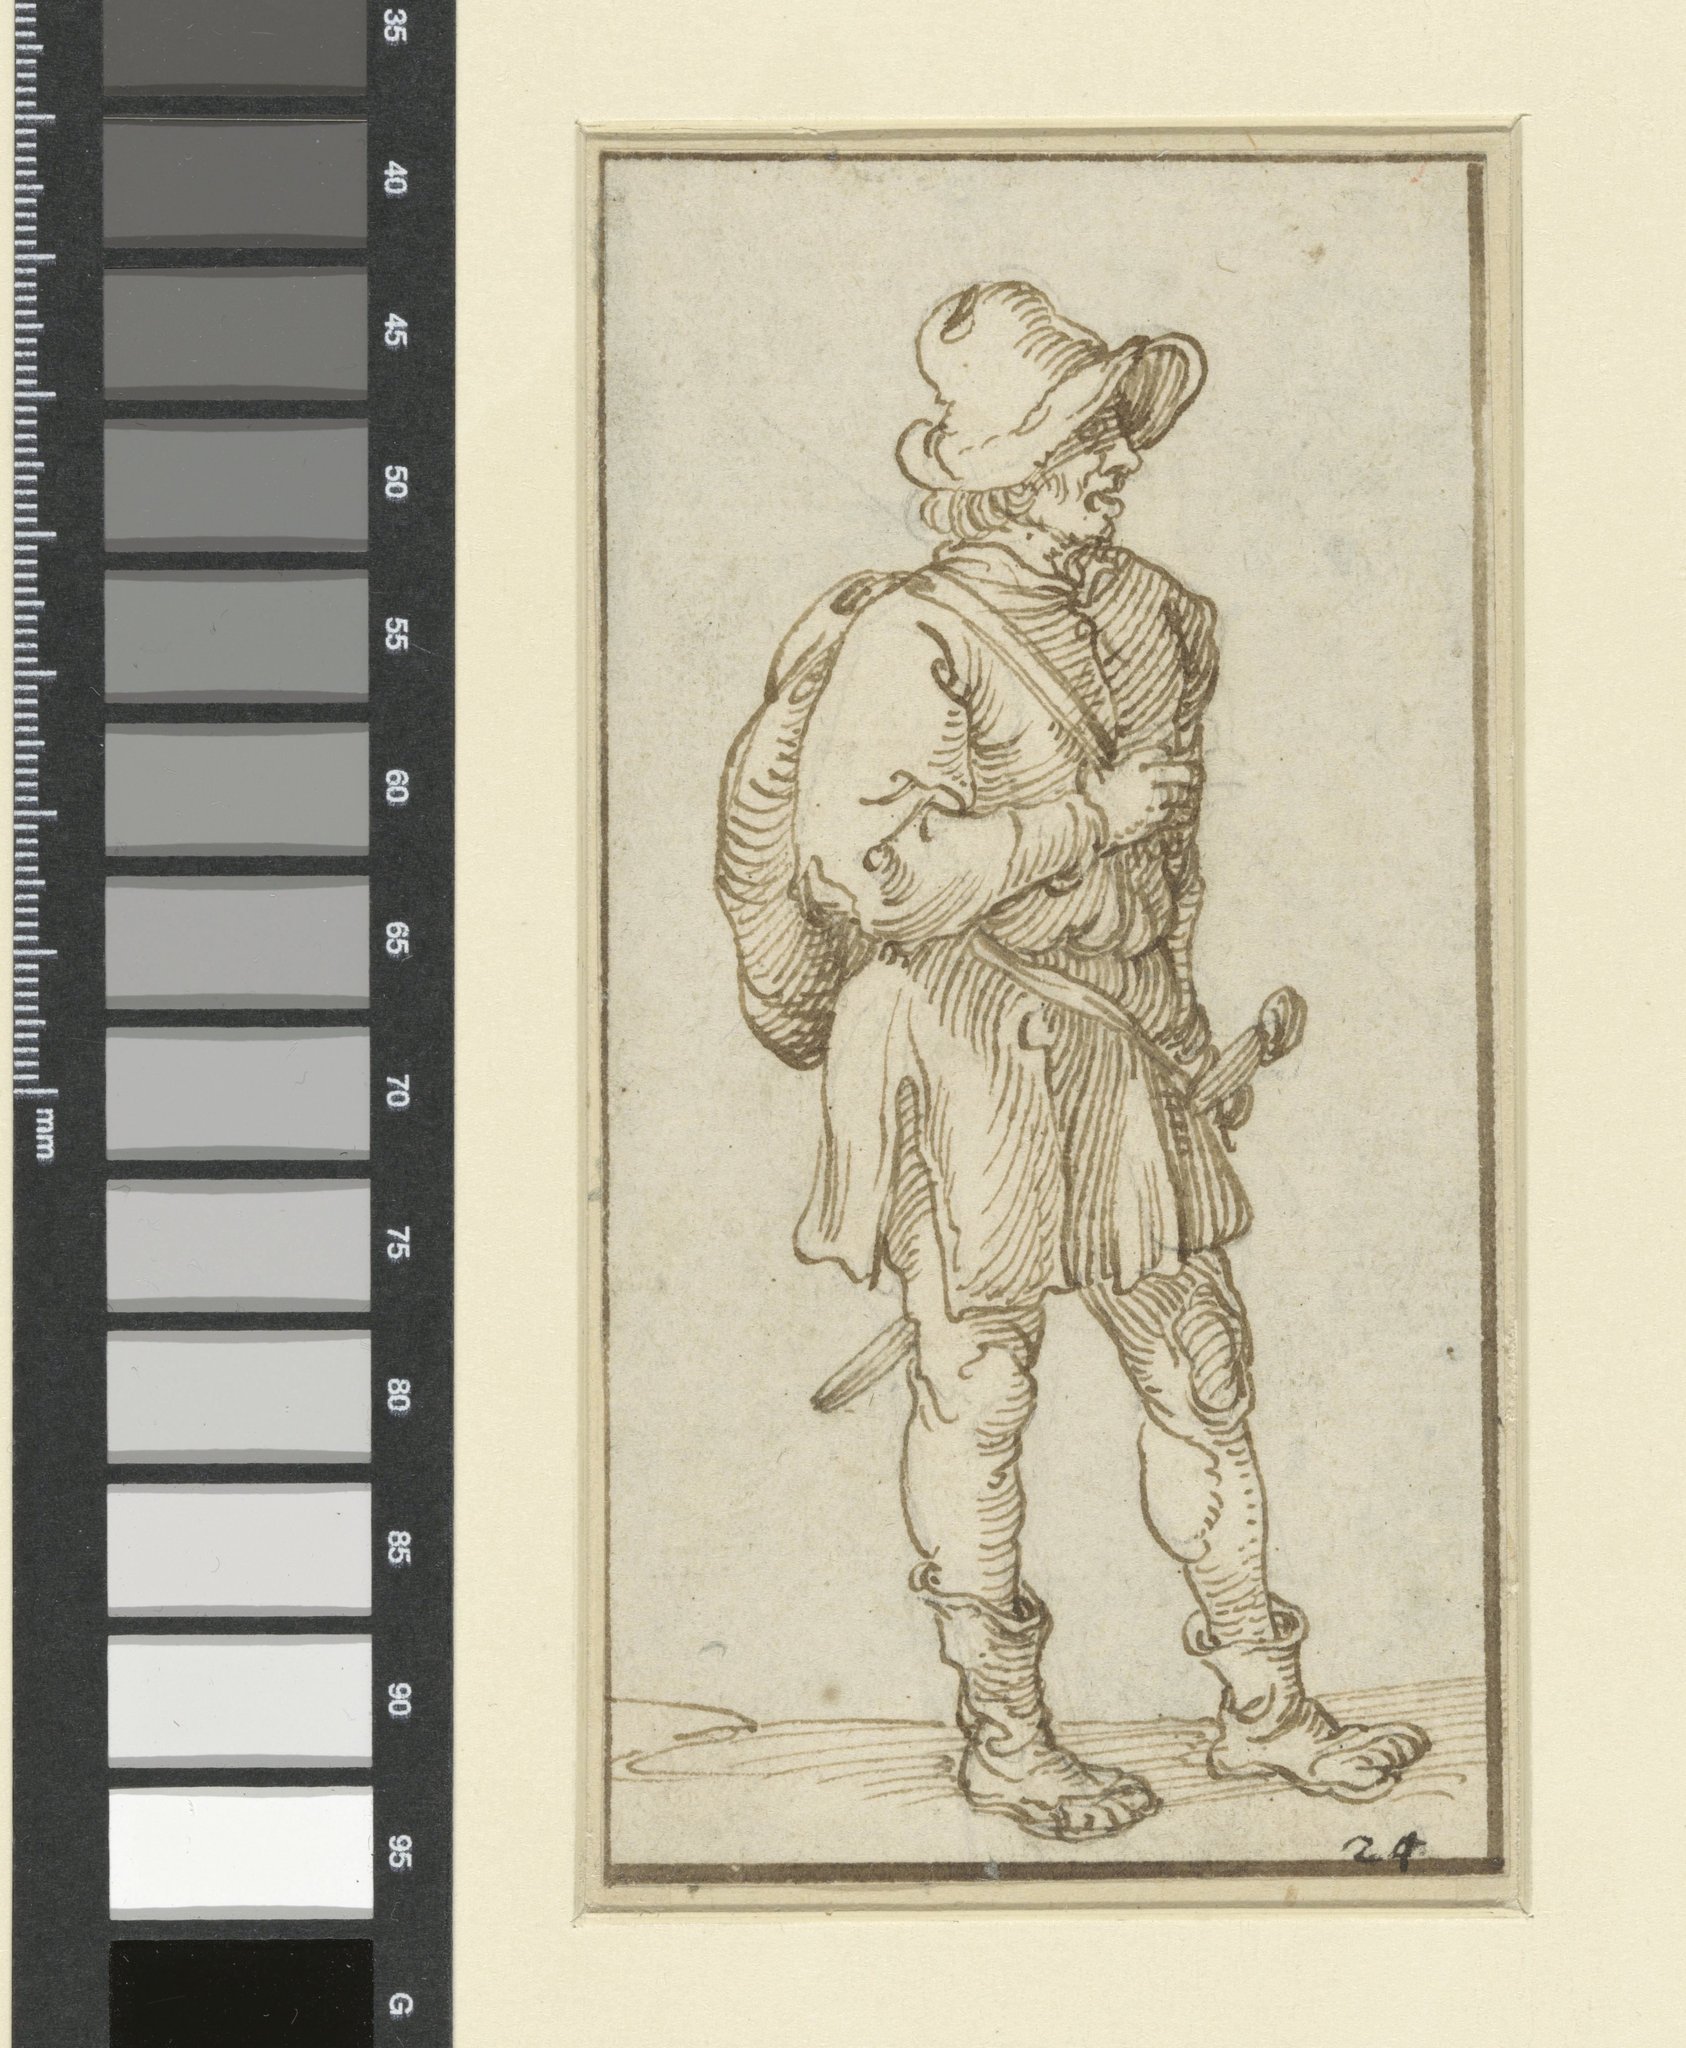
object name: drawing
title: Staande man met rugzak en een zwaard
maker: hans sebald beham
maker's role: designer, draughtsman, print maker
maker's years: 1500-1550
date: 1510-1550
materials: ink, paper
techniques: pen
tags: standing figure